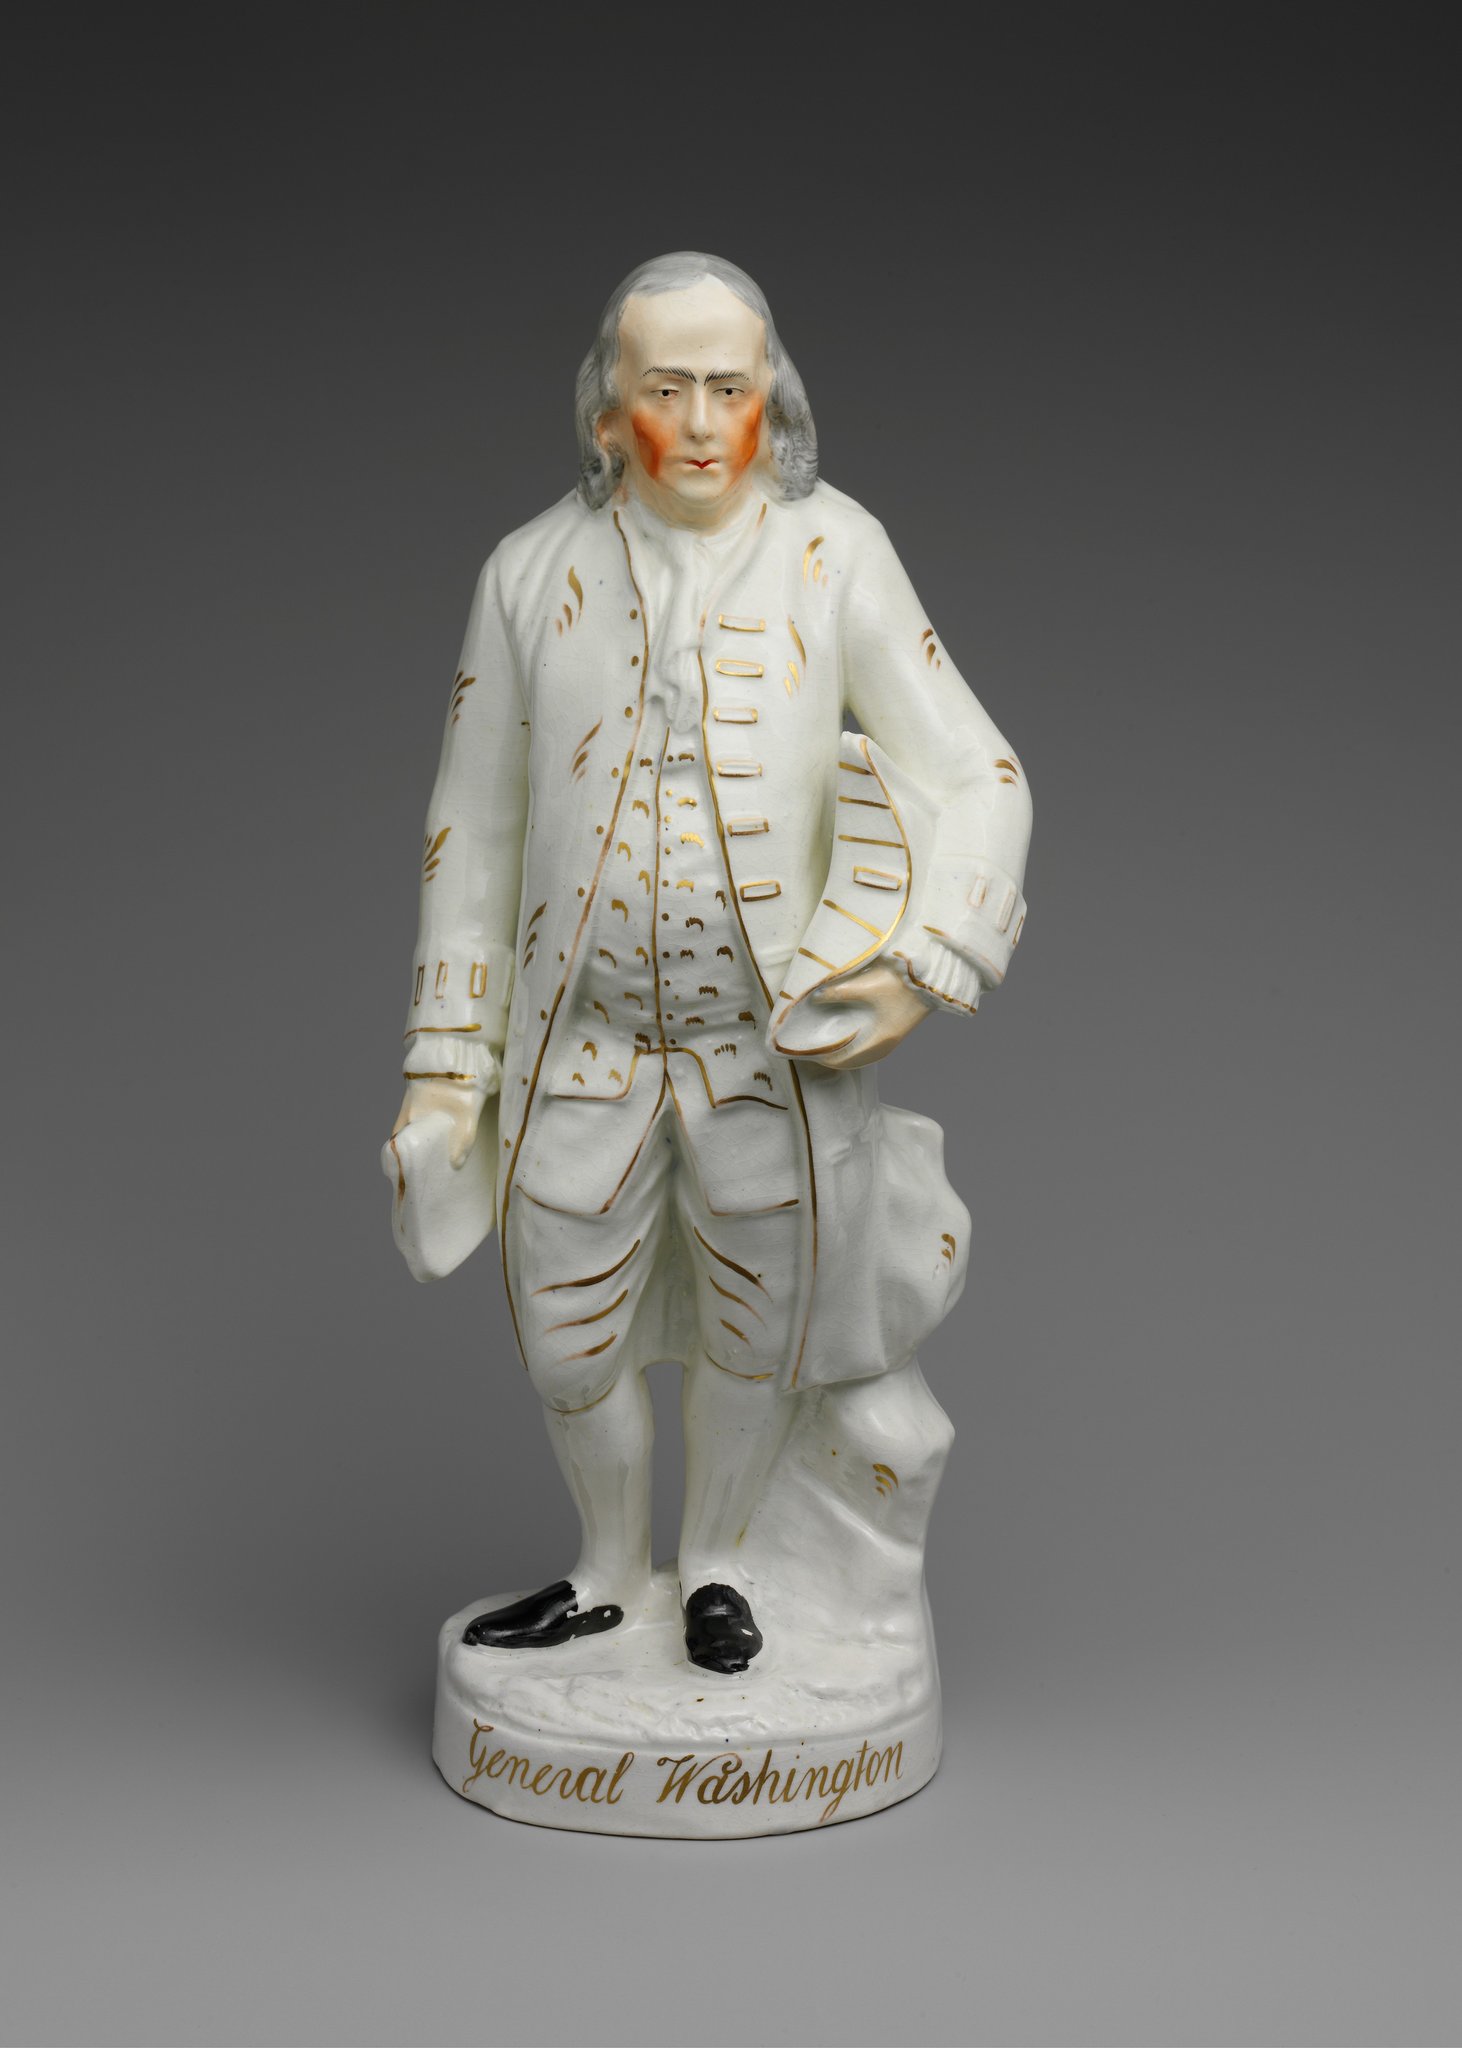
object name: figure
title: Figure of Benjamin Franklin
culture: british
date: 1835-1845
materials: earthenware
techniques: transfer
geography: england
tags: benjamin franklin,men,portraits